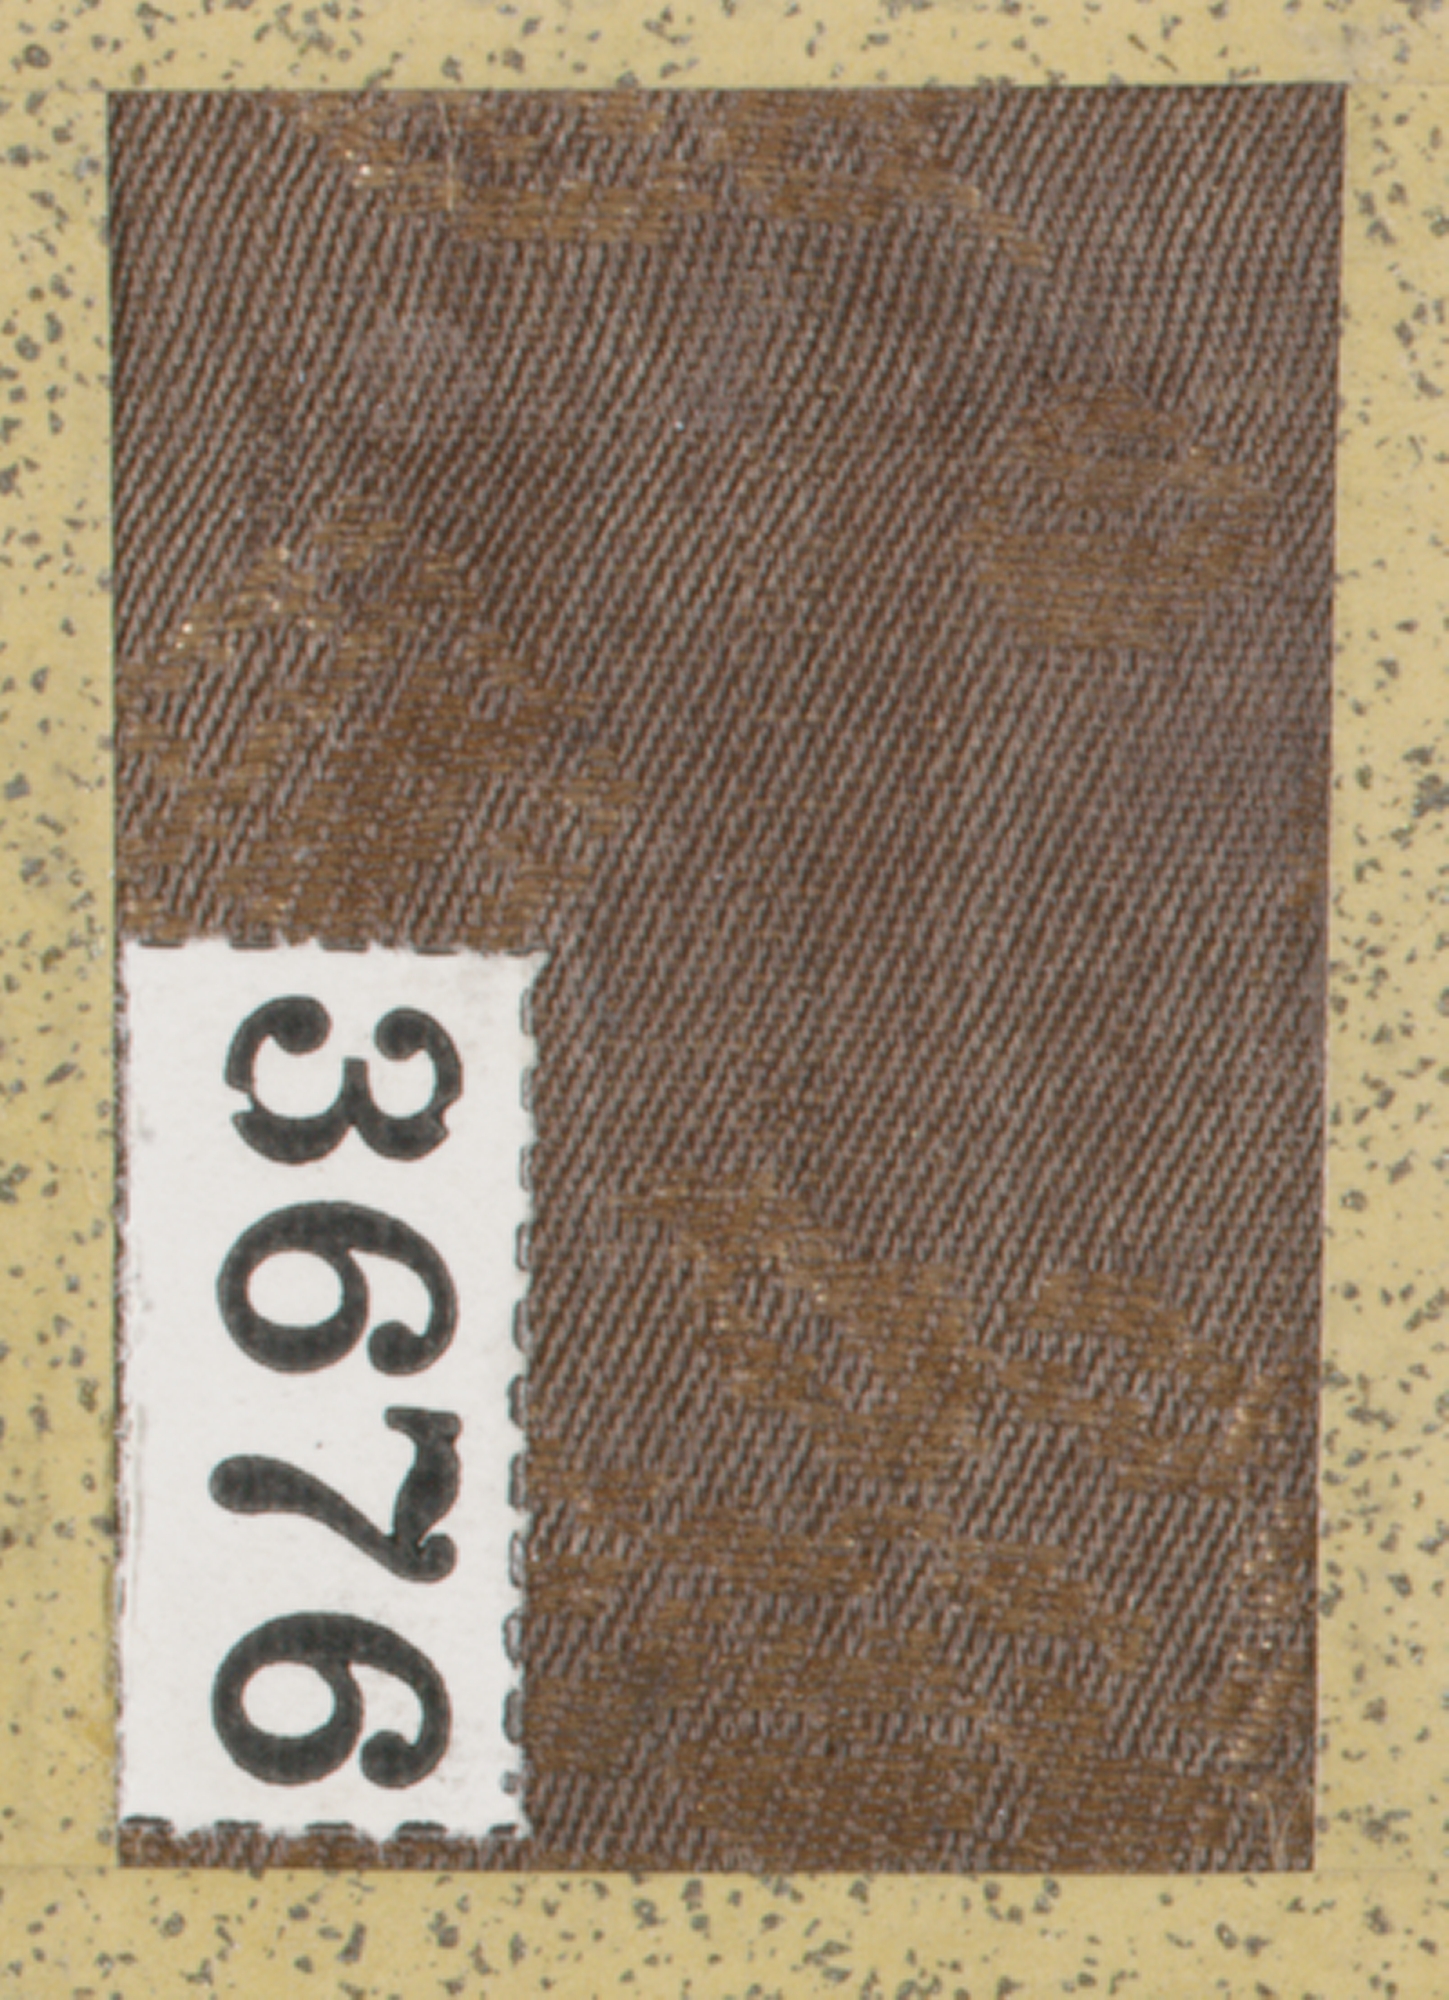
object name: sample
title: Textile Sample from Sample Book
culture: japanese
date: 1801-1900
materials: silk